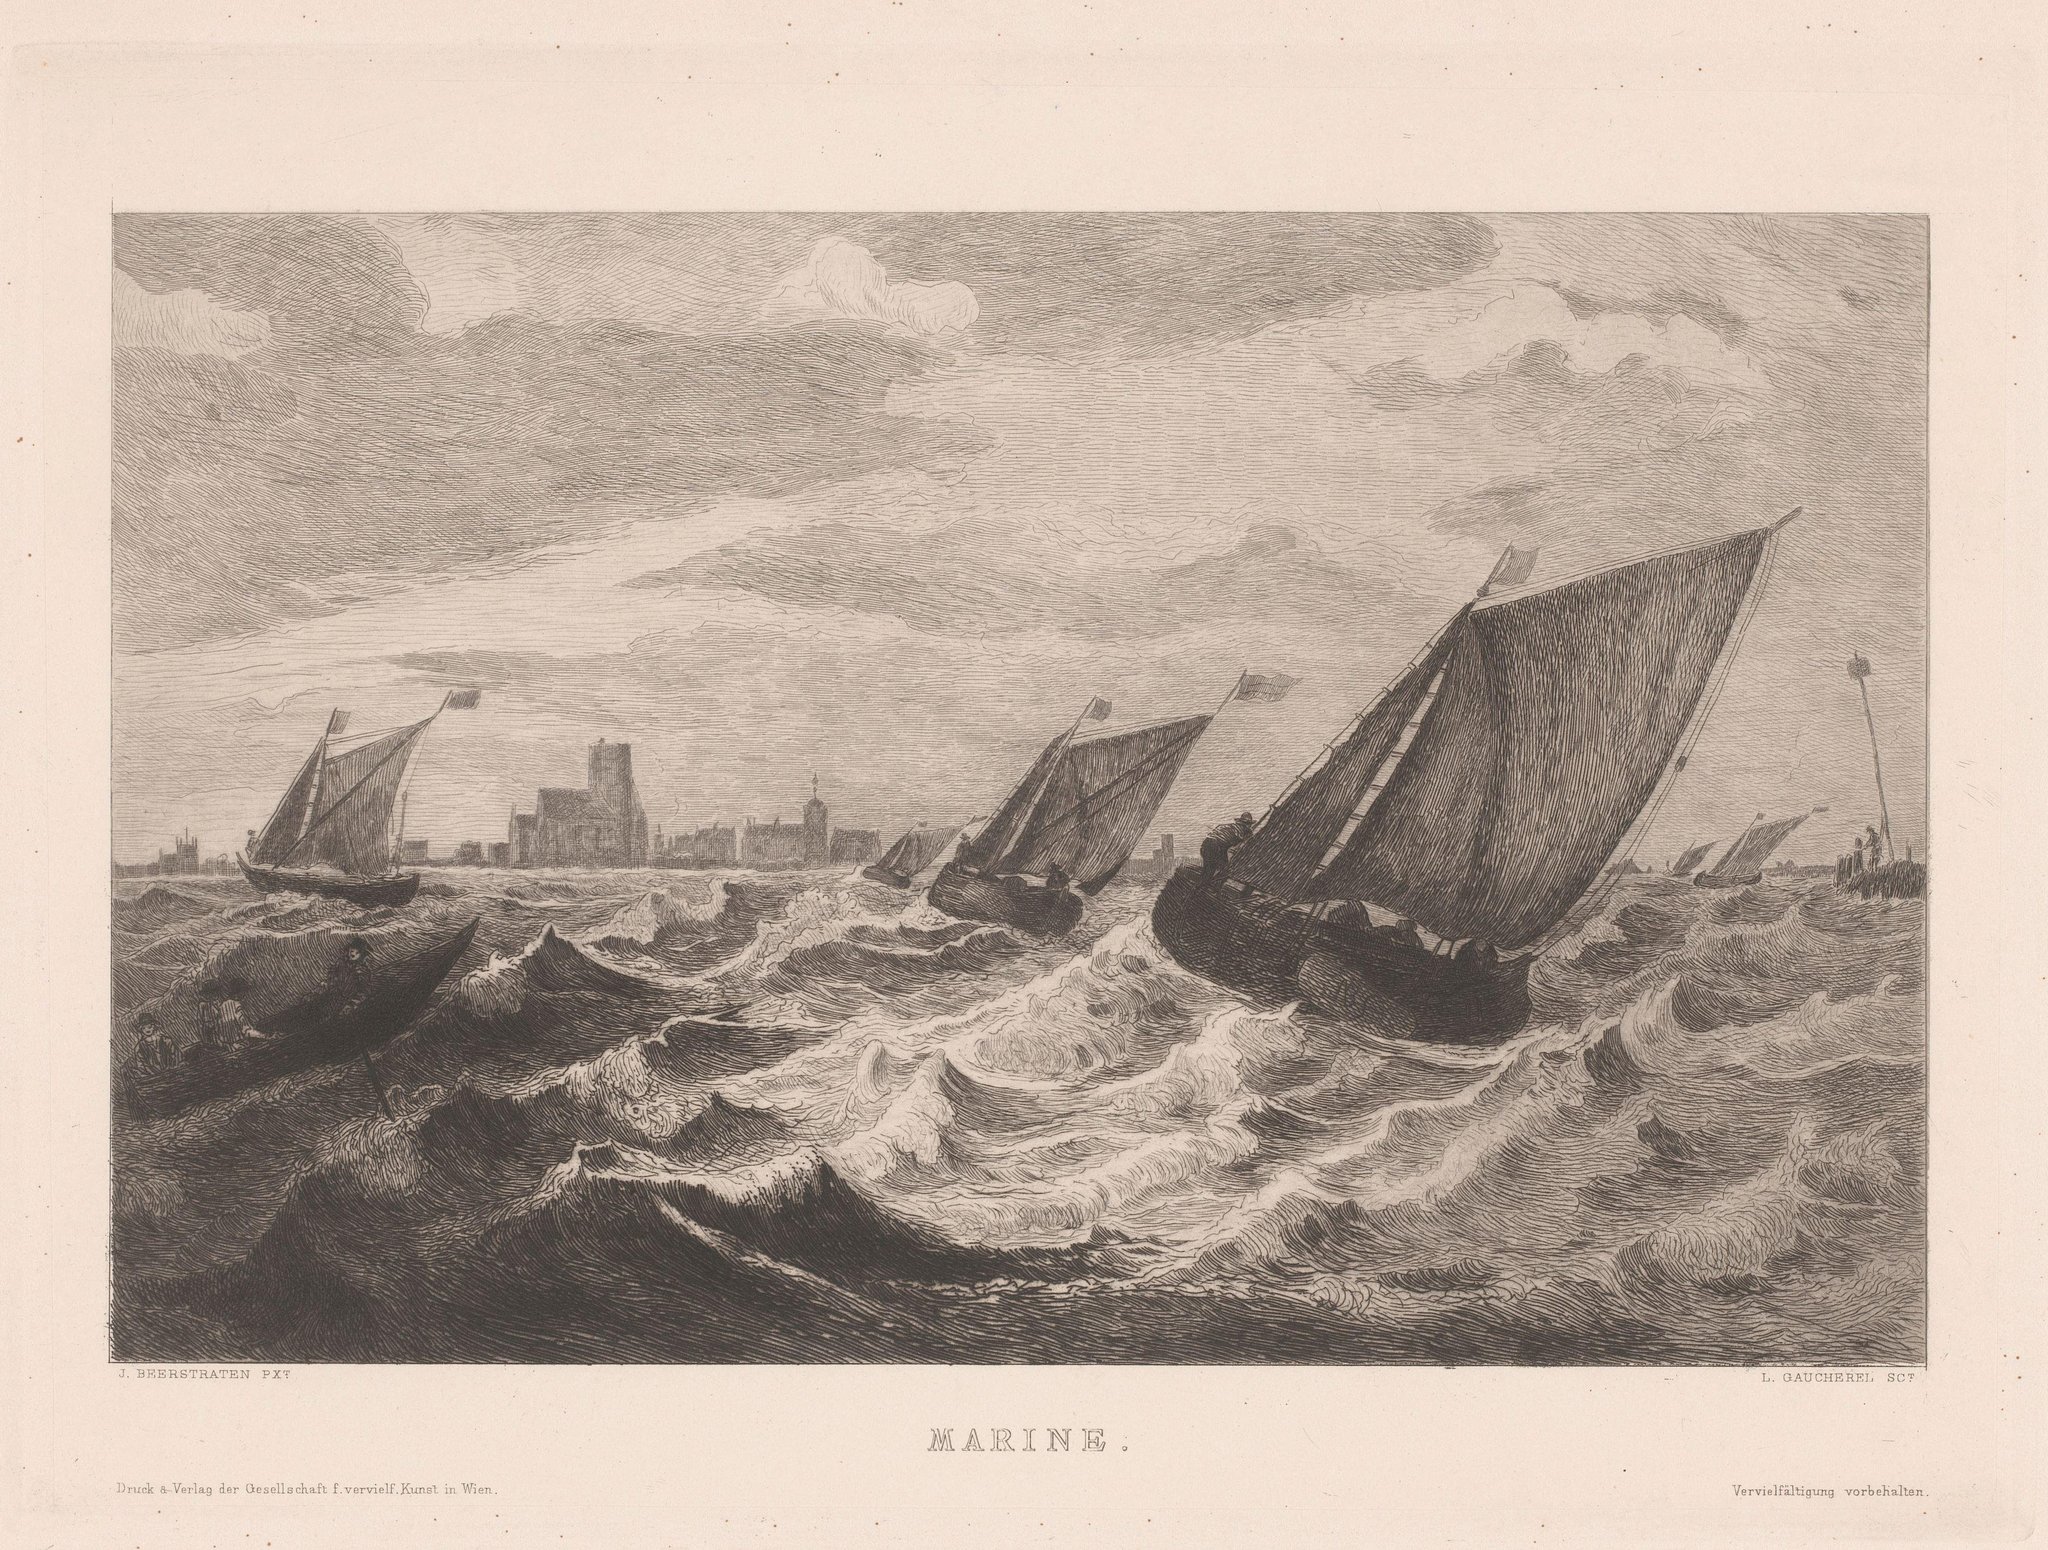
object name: print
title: Zeezicht met schepen op woelig water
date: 1826-1886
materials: paper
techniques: drypoint, etching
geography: france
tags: ships (in general), sea (seascape), storm at sea